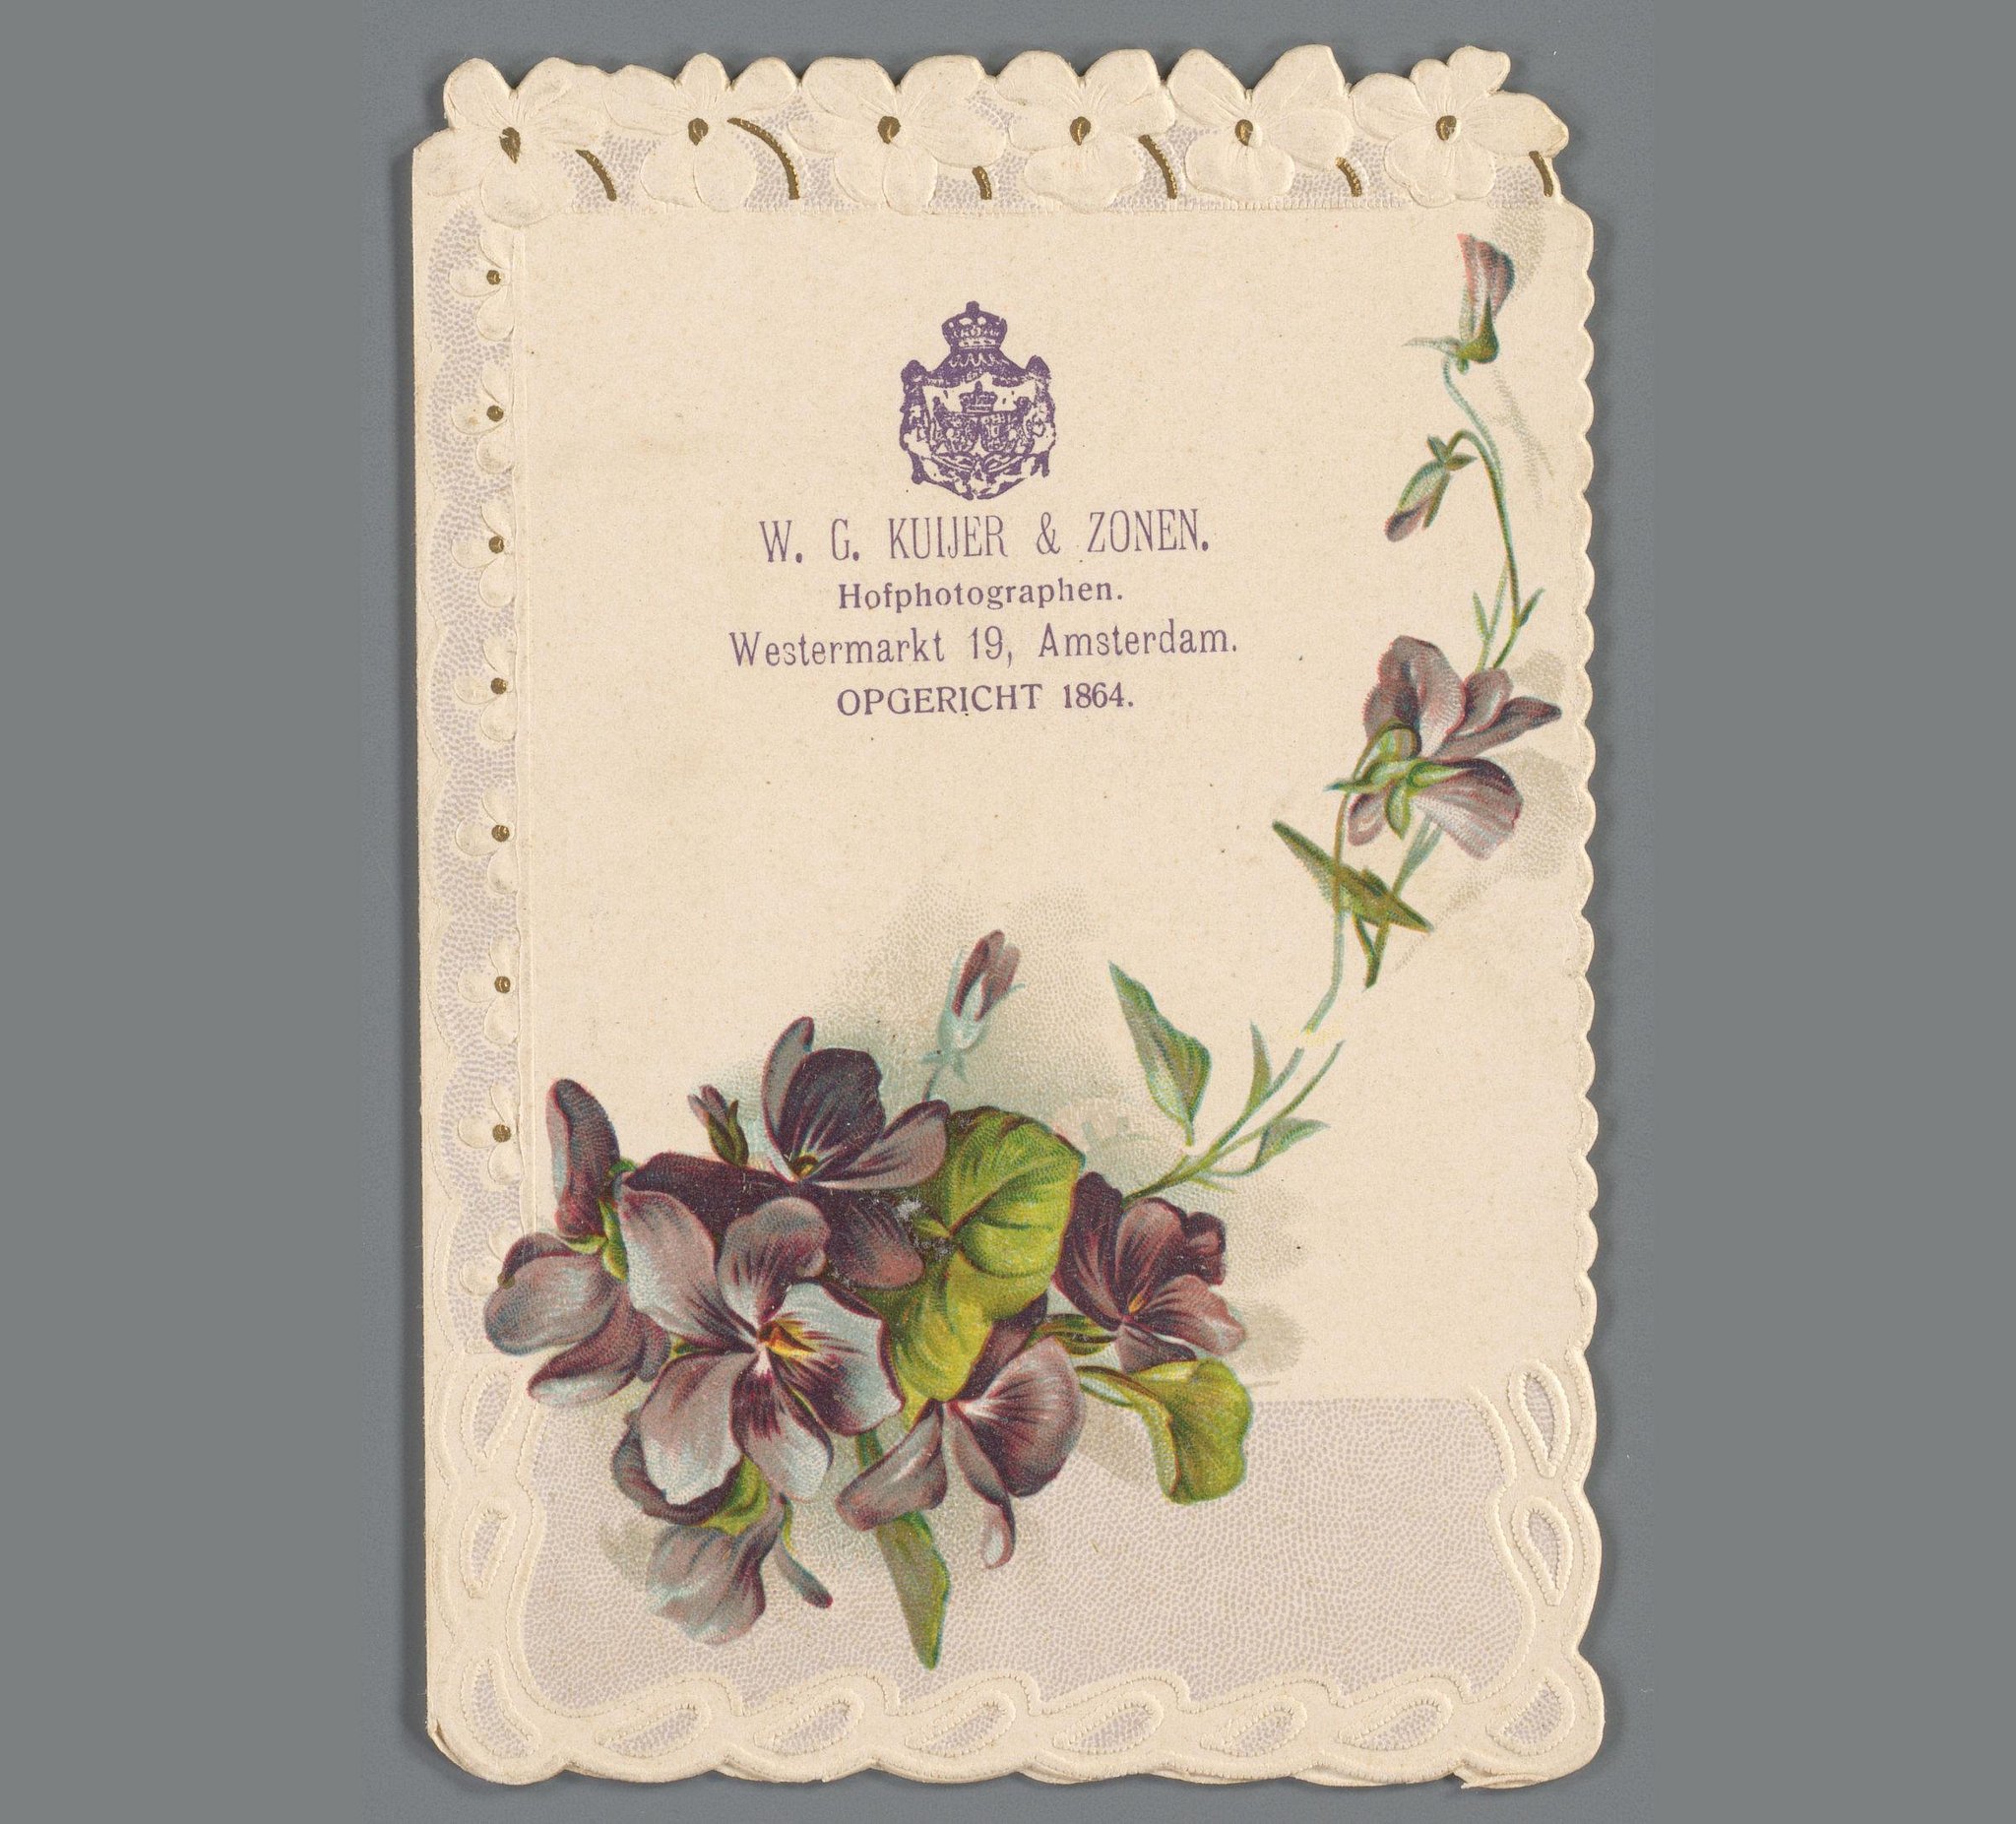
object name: print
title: Prijslijst van fotoatelier W.G. Kuijer en Zonen, met op de voorzijde afbeelding van een boeket viooltjes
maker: Anonymous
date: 1880-1906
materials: cardboard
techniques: blind stamped, lithograph, letterpress printing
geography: amsterdam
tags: flowers